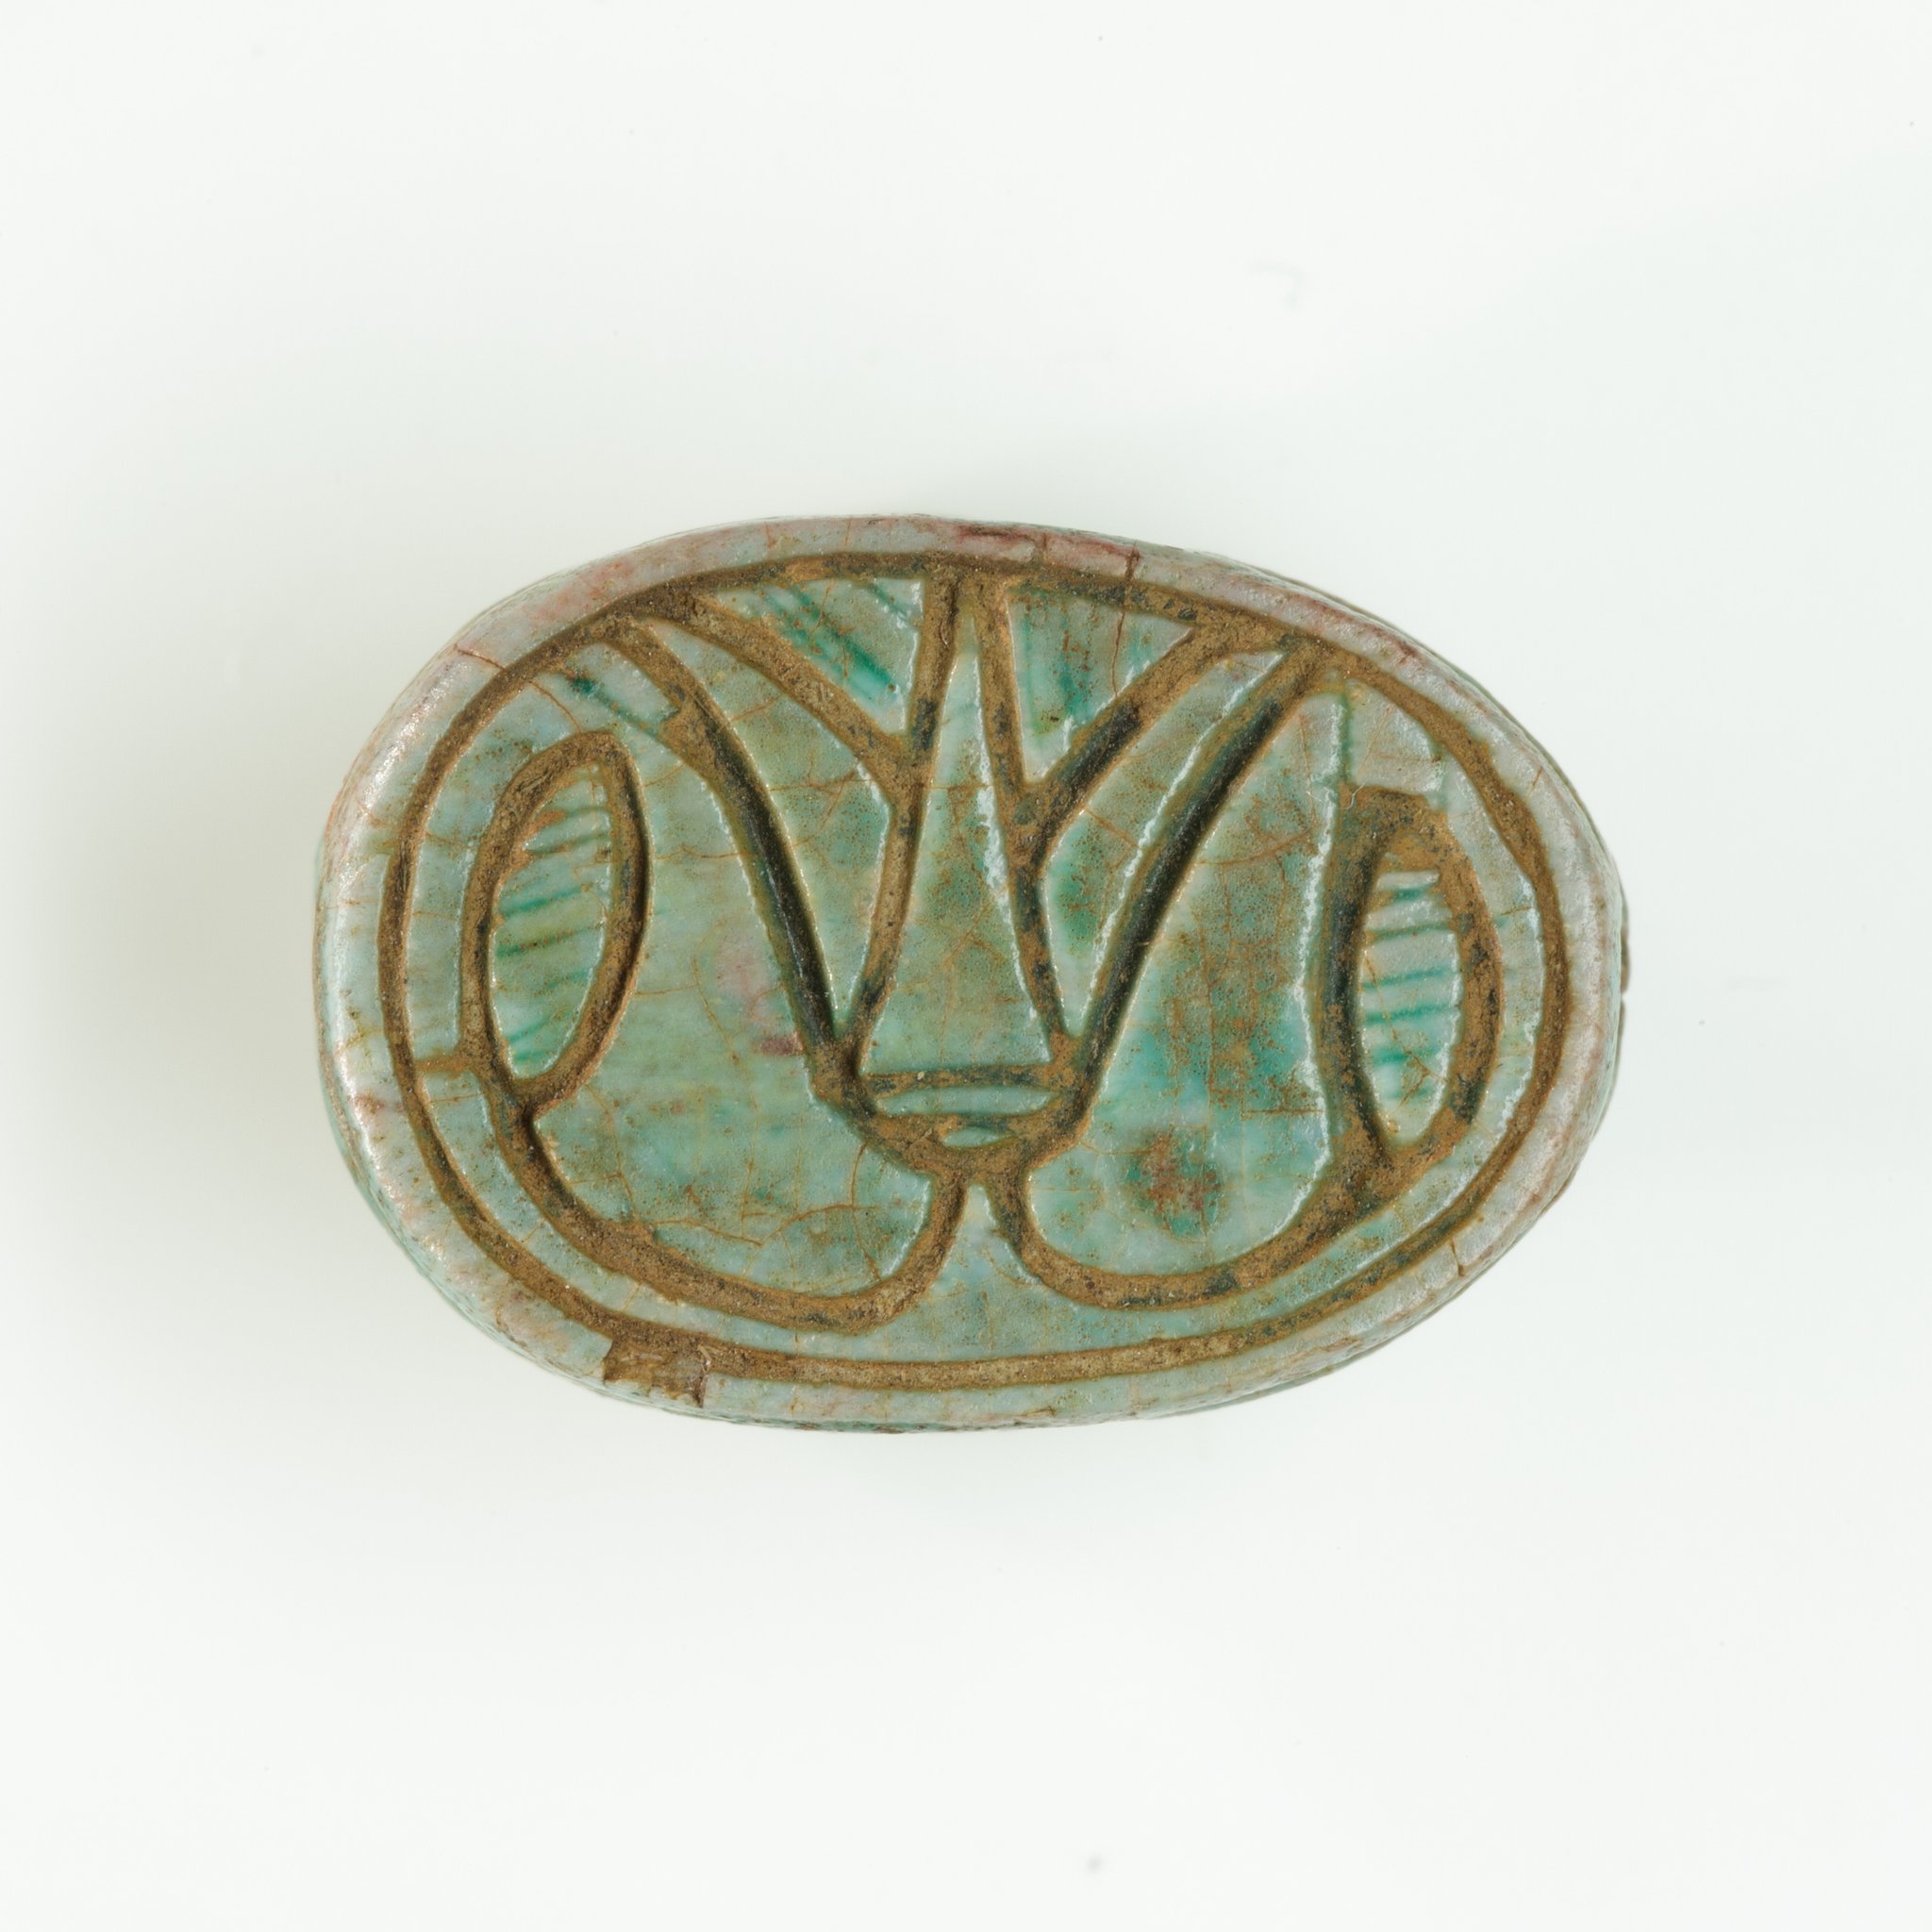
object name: scarab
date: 1550-1295 BCE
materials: stone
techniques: glazing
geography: egypt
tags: scarabs